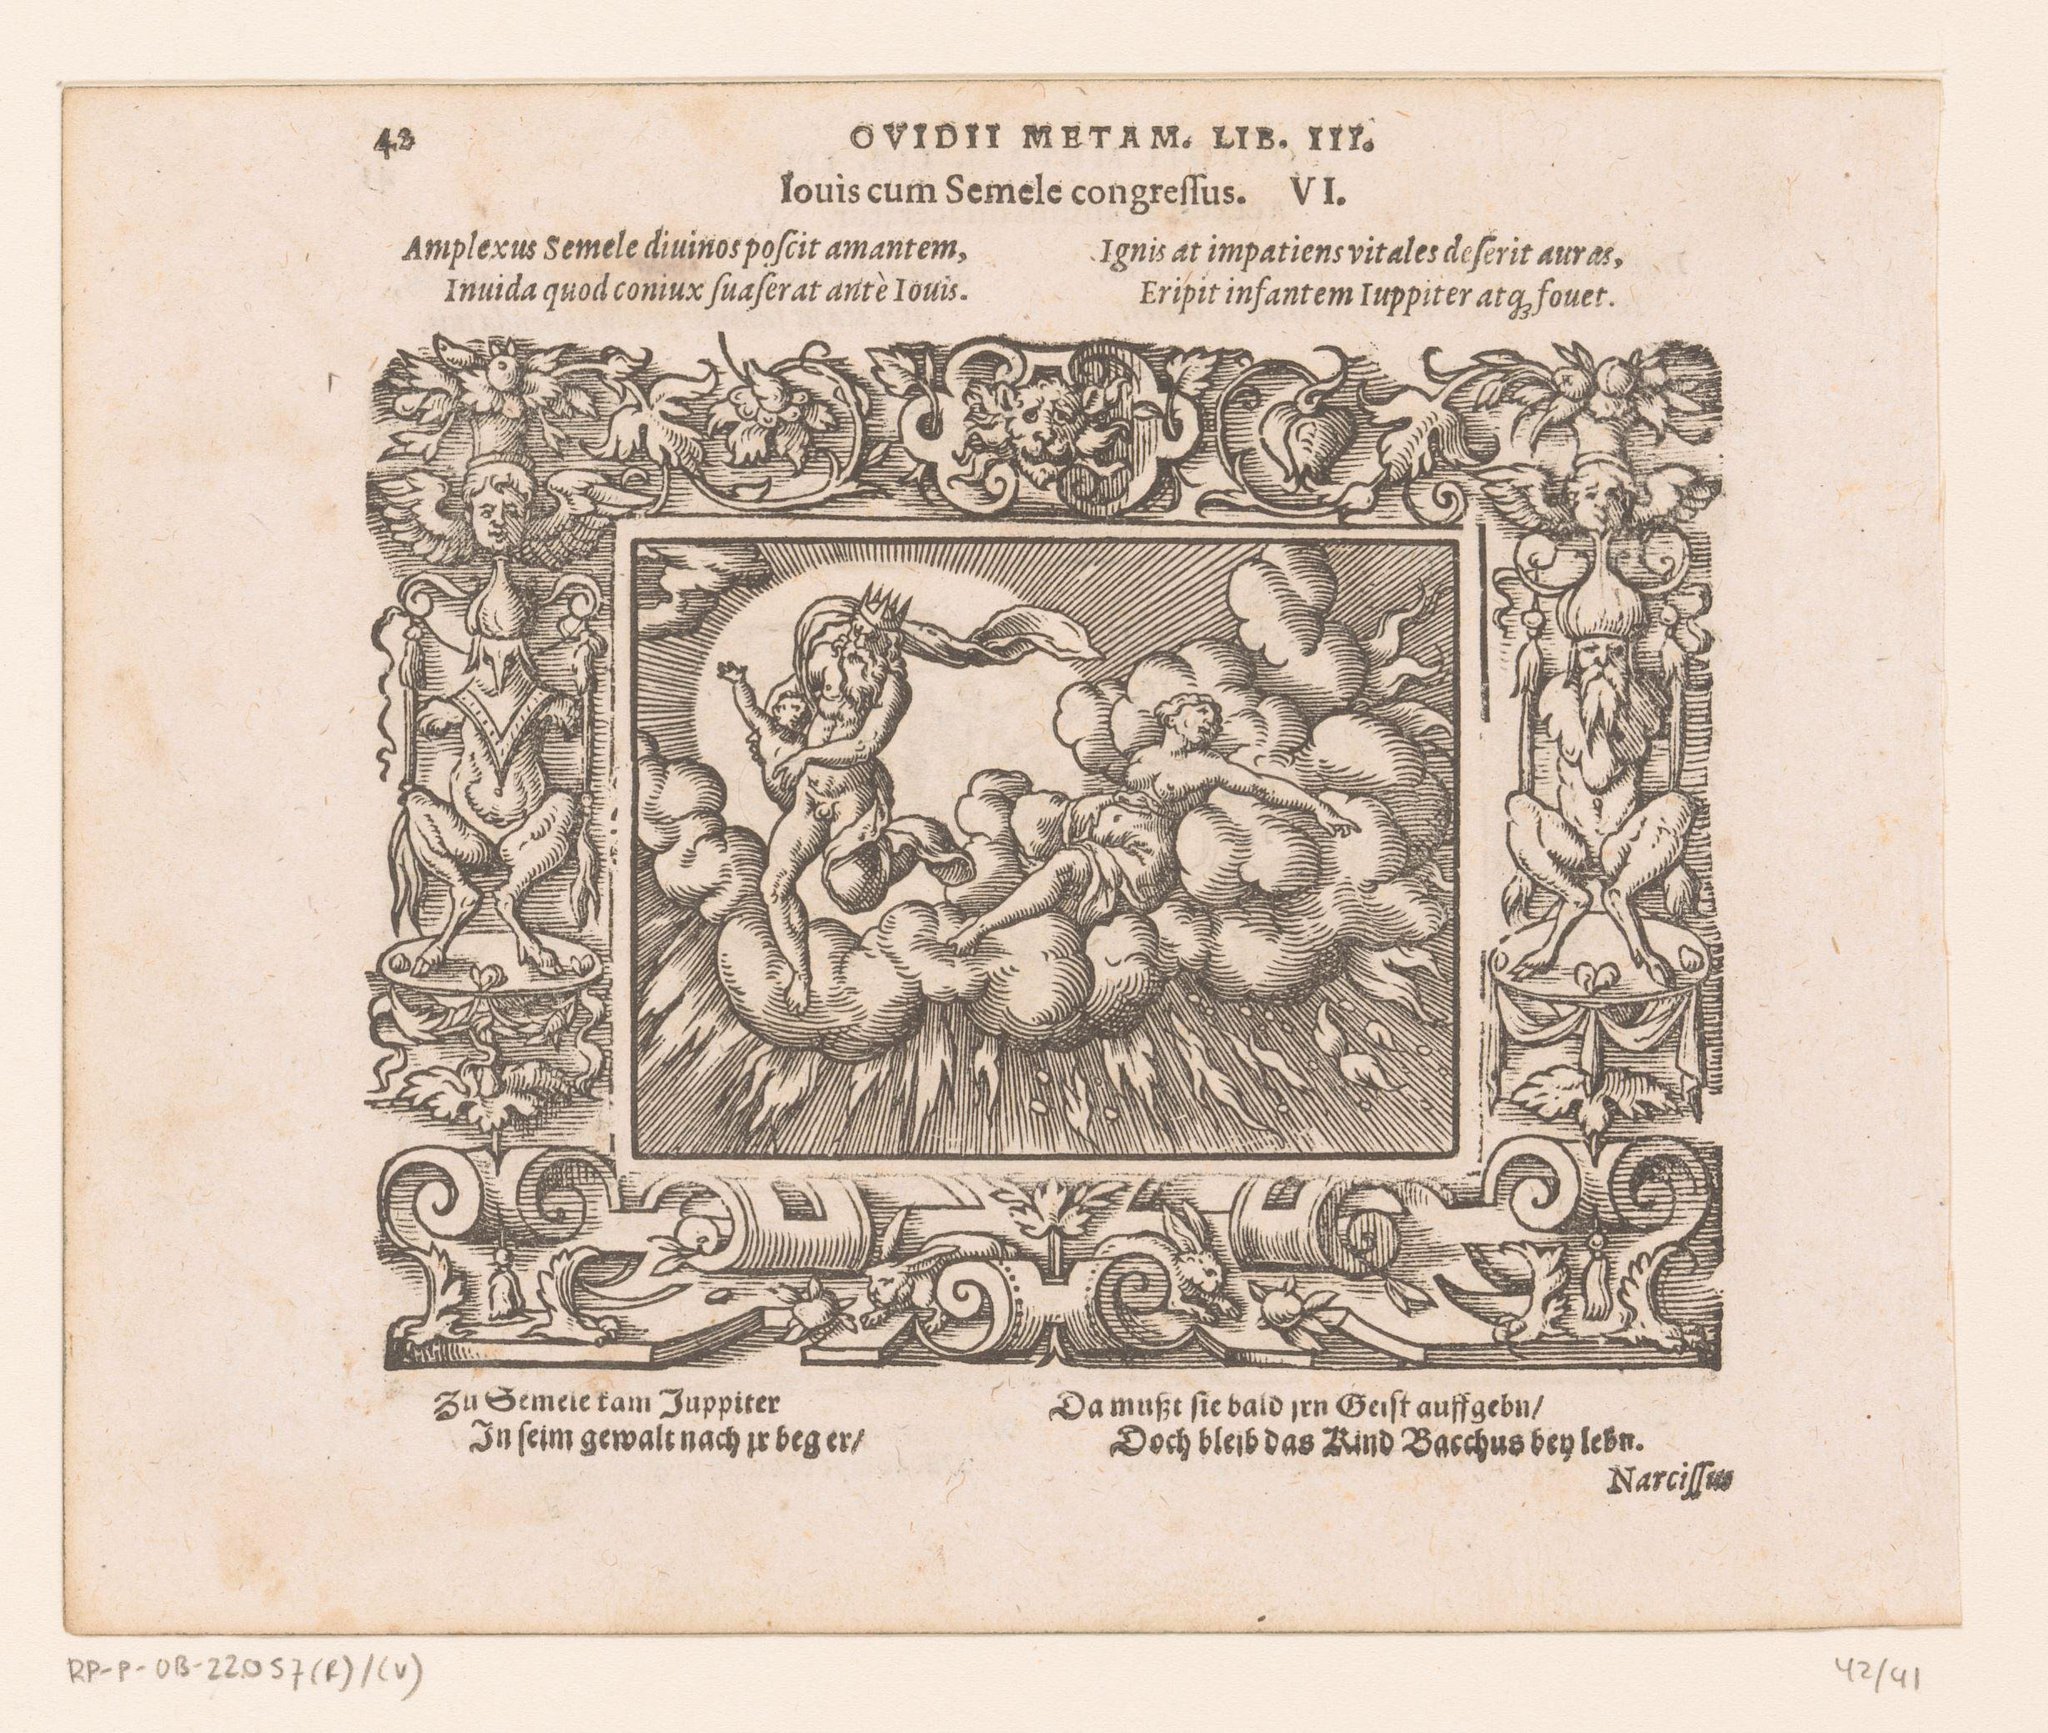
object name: book illustration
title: Jupiter en Semele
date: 1569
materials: paper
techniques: letterpress printing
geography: nuremberg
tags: jupiter kills semele by coming to her with his lightning and thunderbolts, scrollwork, strapwork ~ ornament, jupiter rescues the baby bacchus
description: Illustratie bij de Metamorfosen van Ovidius, afkomstig uit de publicatie: Posthius, Johannes. Tetrasticha in Ovidii metam. Frankfurt am Main: Georg Rab en Sigmund Feyerabend en erven Weigand Han, 1569. De voorstellingen en ornamentranden van deze boekillustraties zijn van twee aparte blokken gedrukt. Beide werden afzonderlijk van elkaar ook gebruikt voor andere publicaties, en de ornamentranden werden eveneens binnen deze publicatie meerdere keren gebruikt.